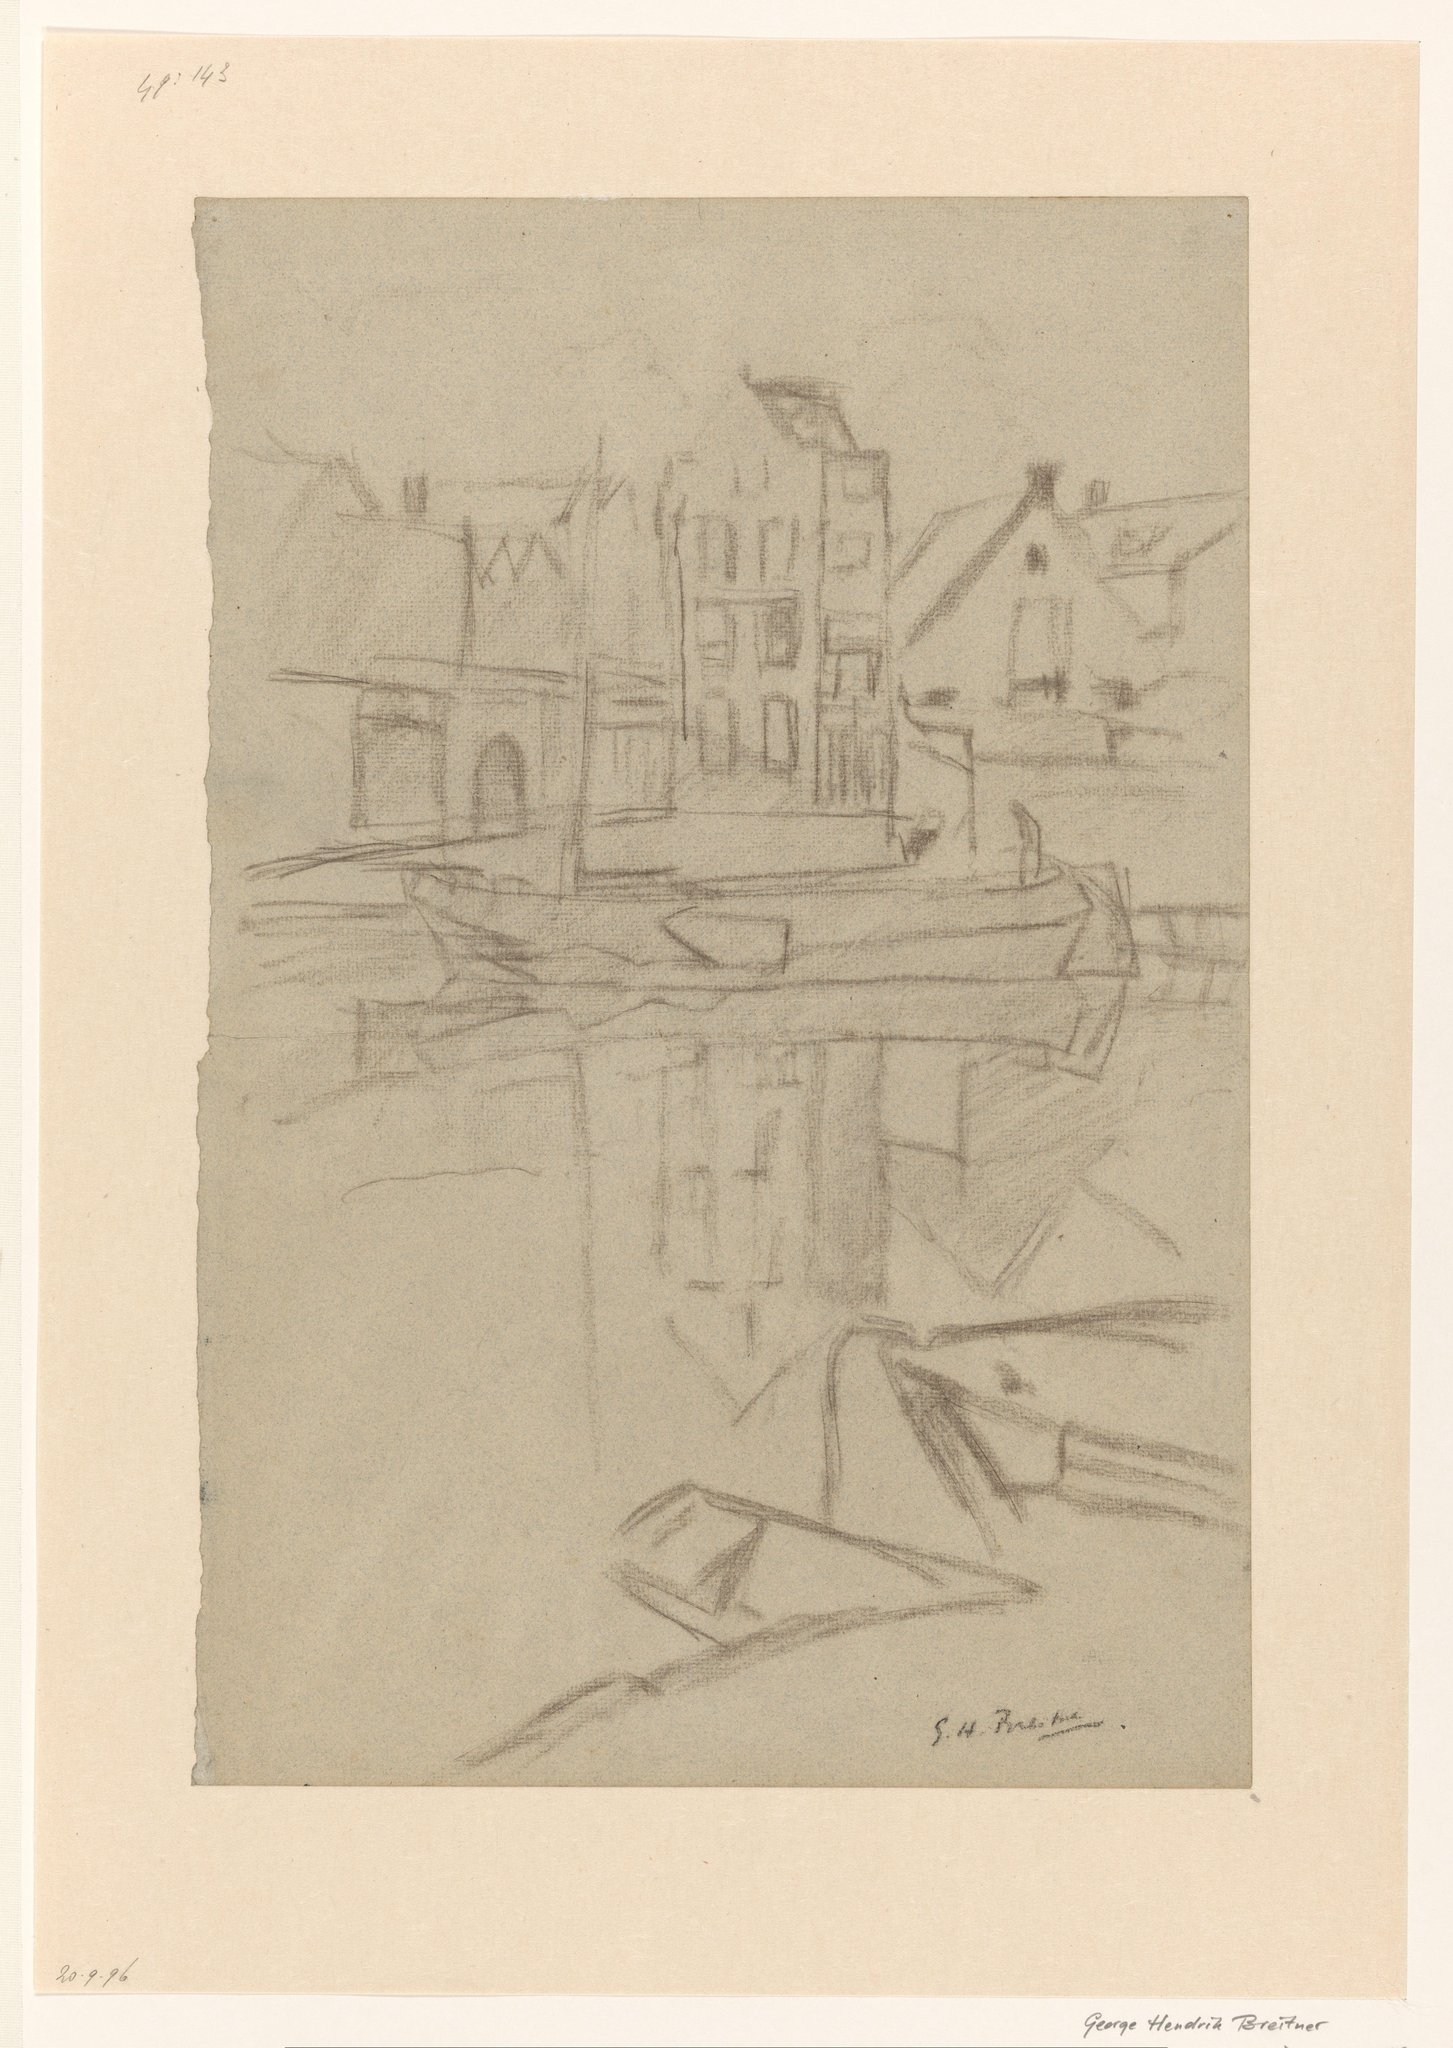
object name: drawing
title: Stadsgracht met boten en spiegelende huizen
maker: george hendrik breitner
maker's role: draughtsman, painter, print maker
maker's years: 1857-1923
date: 1867-1923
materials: charcoal, paper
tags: canals, waters (in city), amsterdam